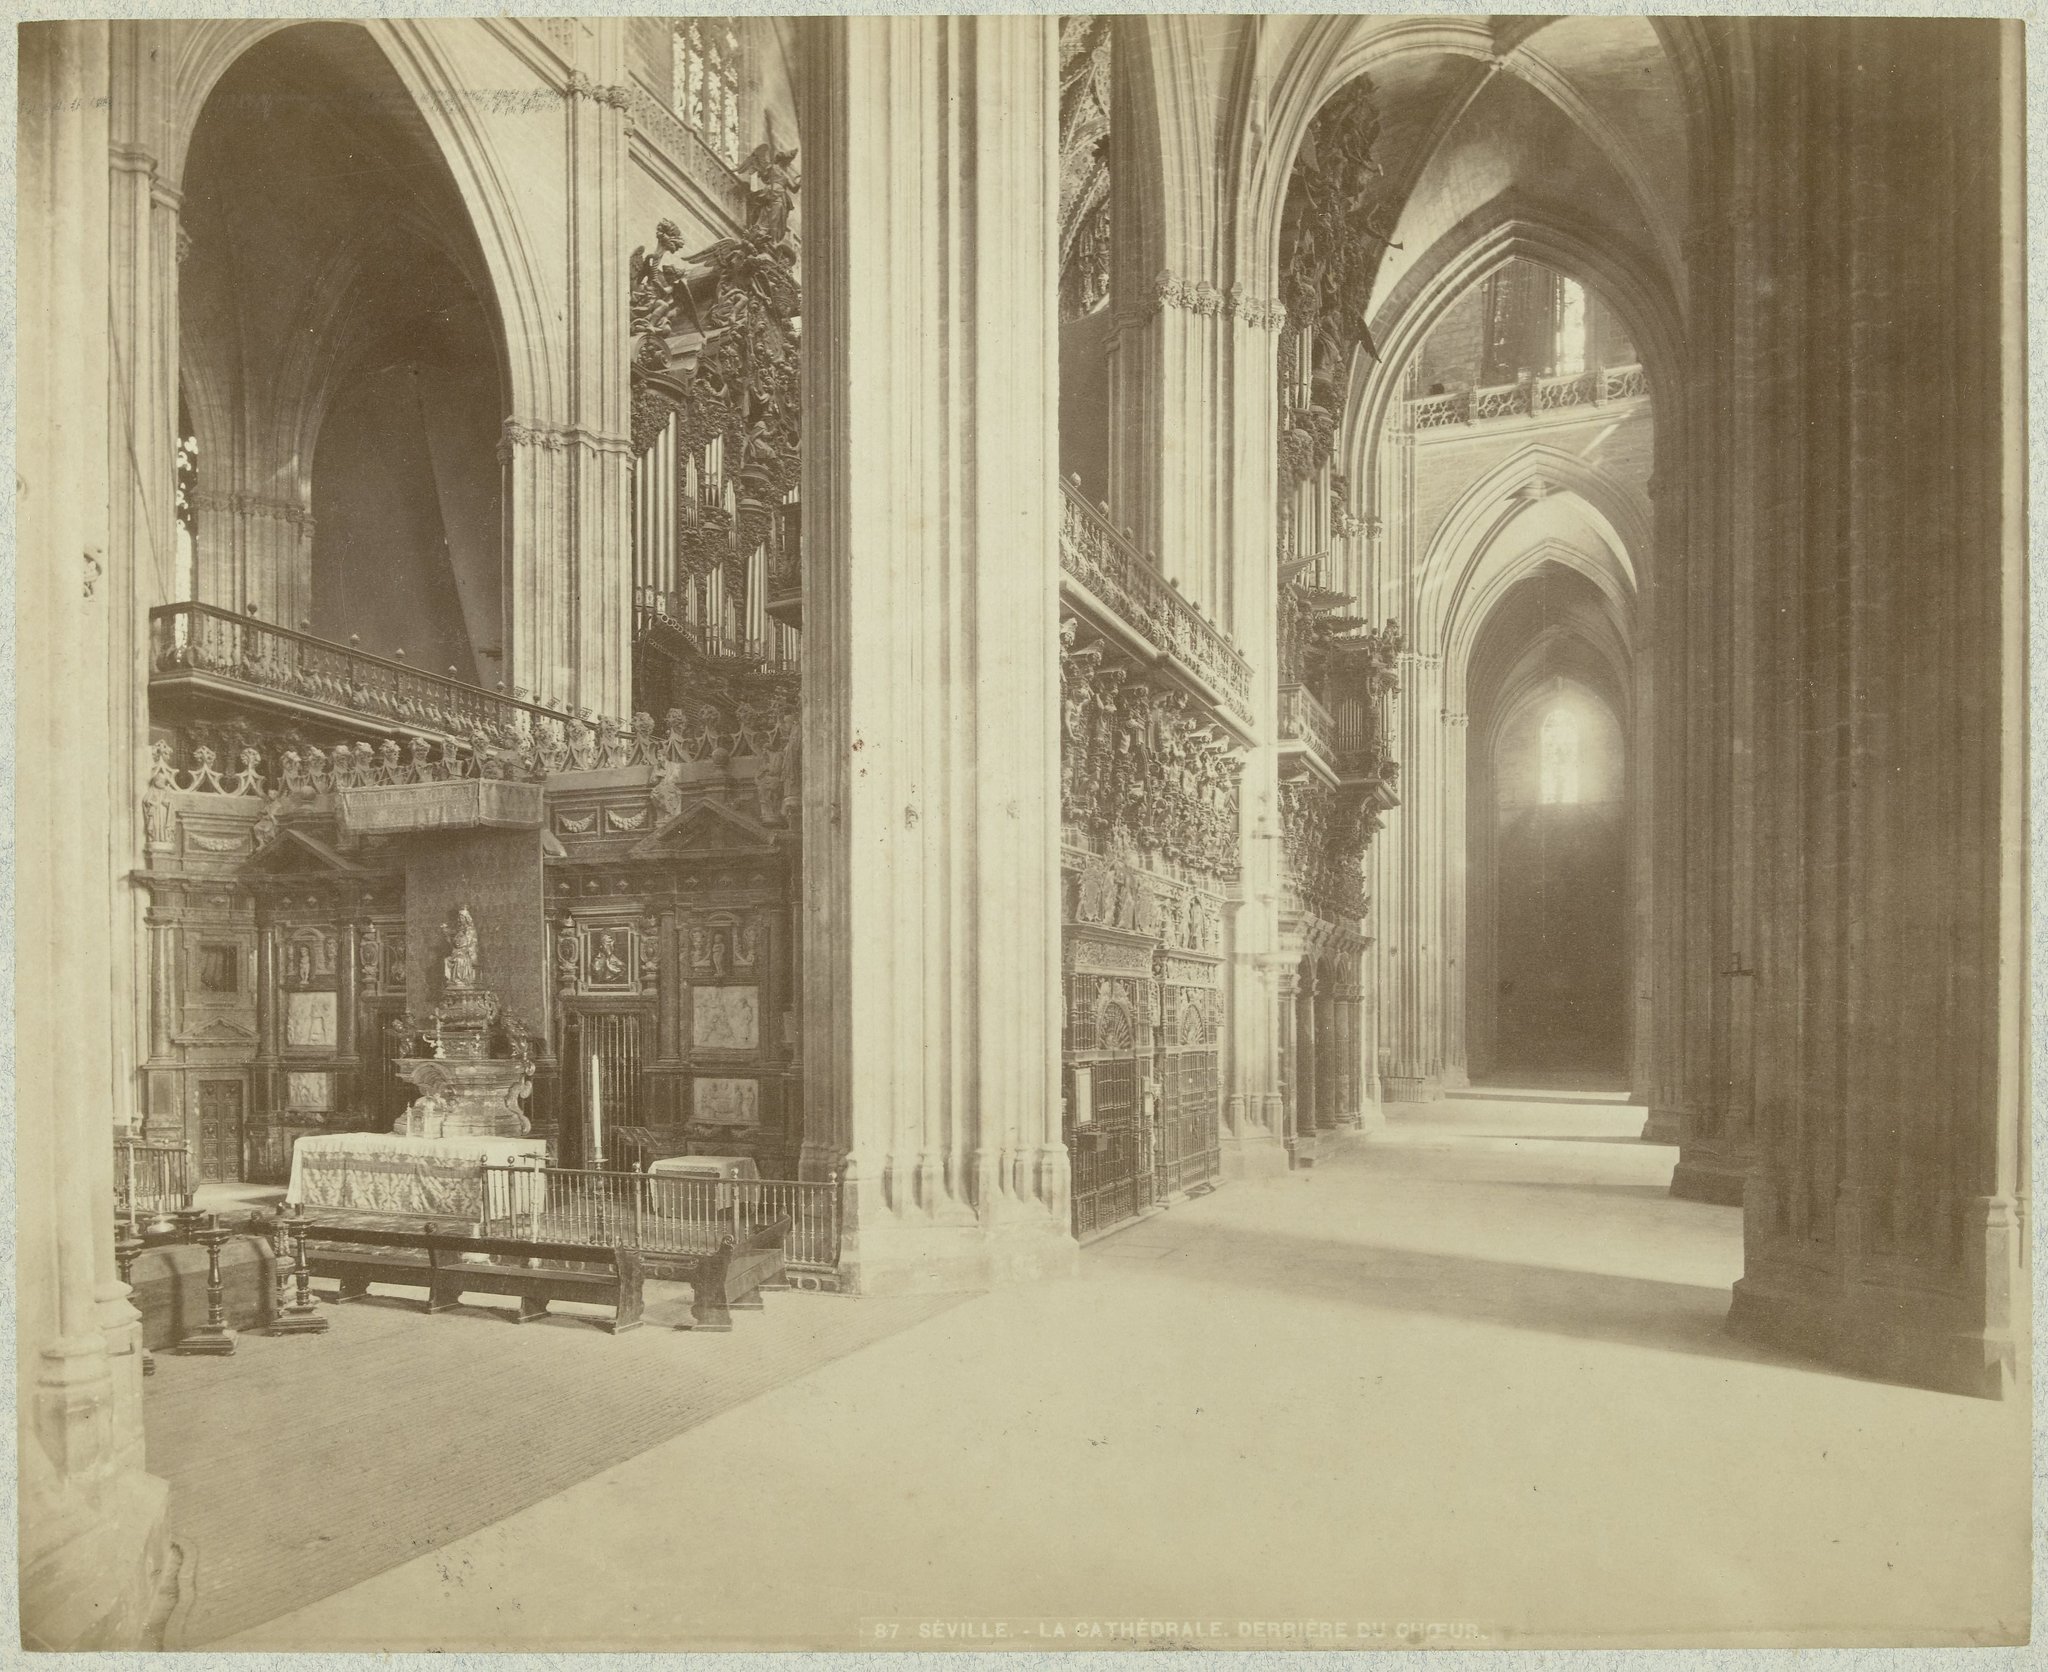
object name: photograph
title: Seville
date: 1864-1920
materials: cardboard, paper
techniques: albumen print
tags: interior of church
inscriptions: inscription: ‘Sevilla’, number: ‘87’